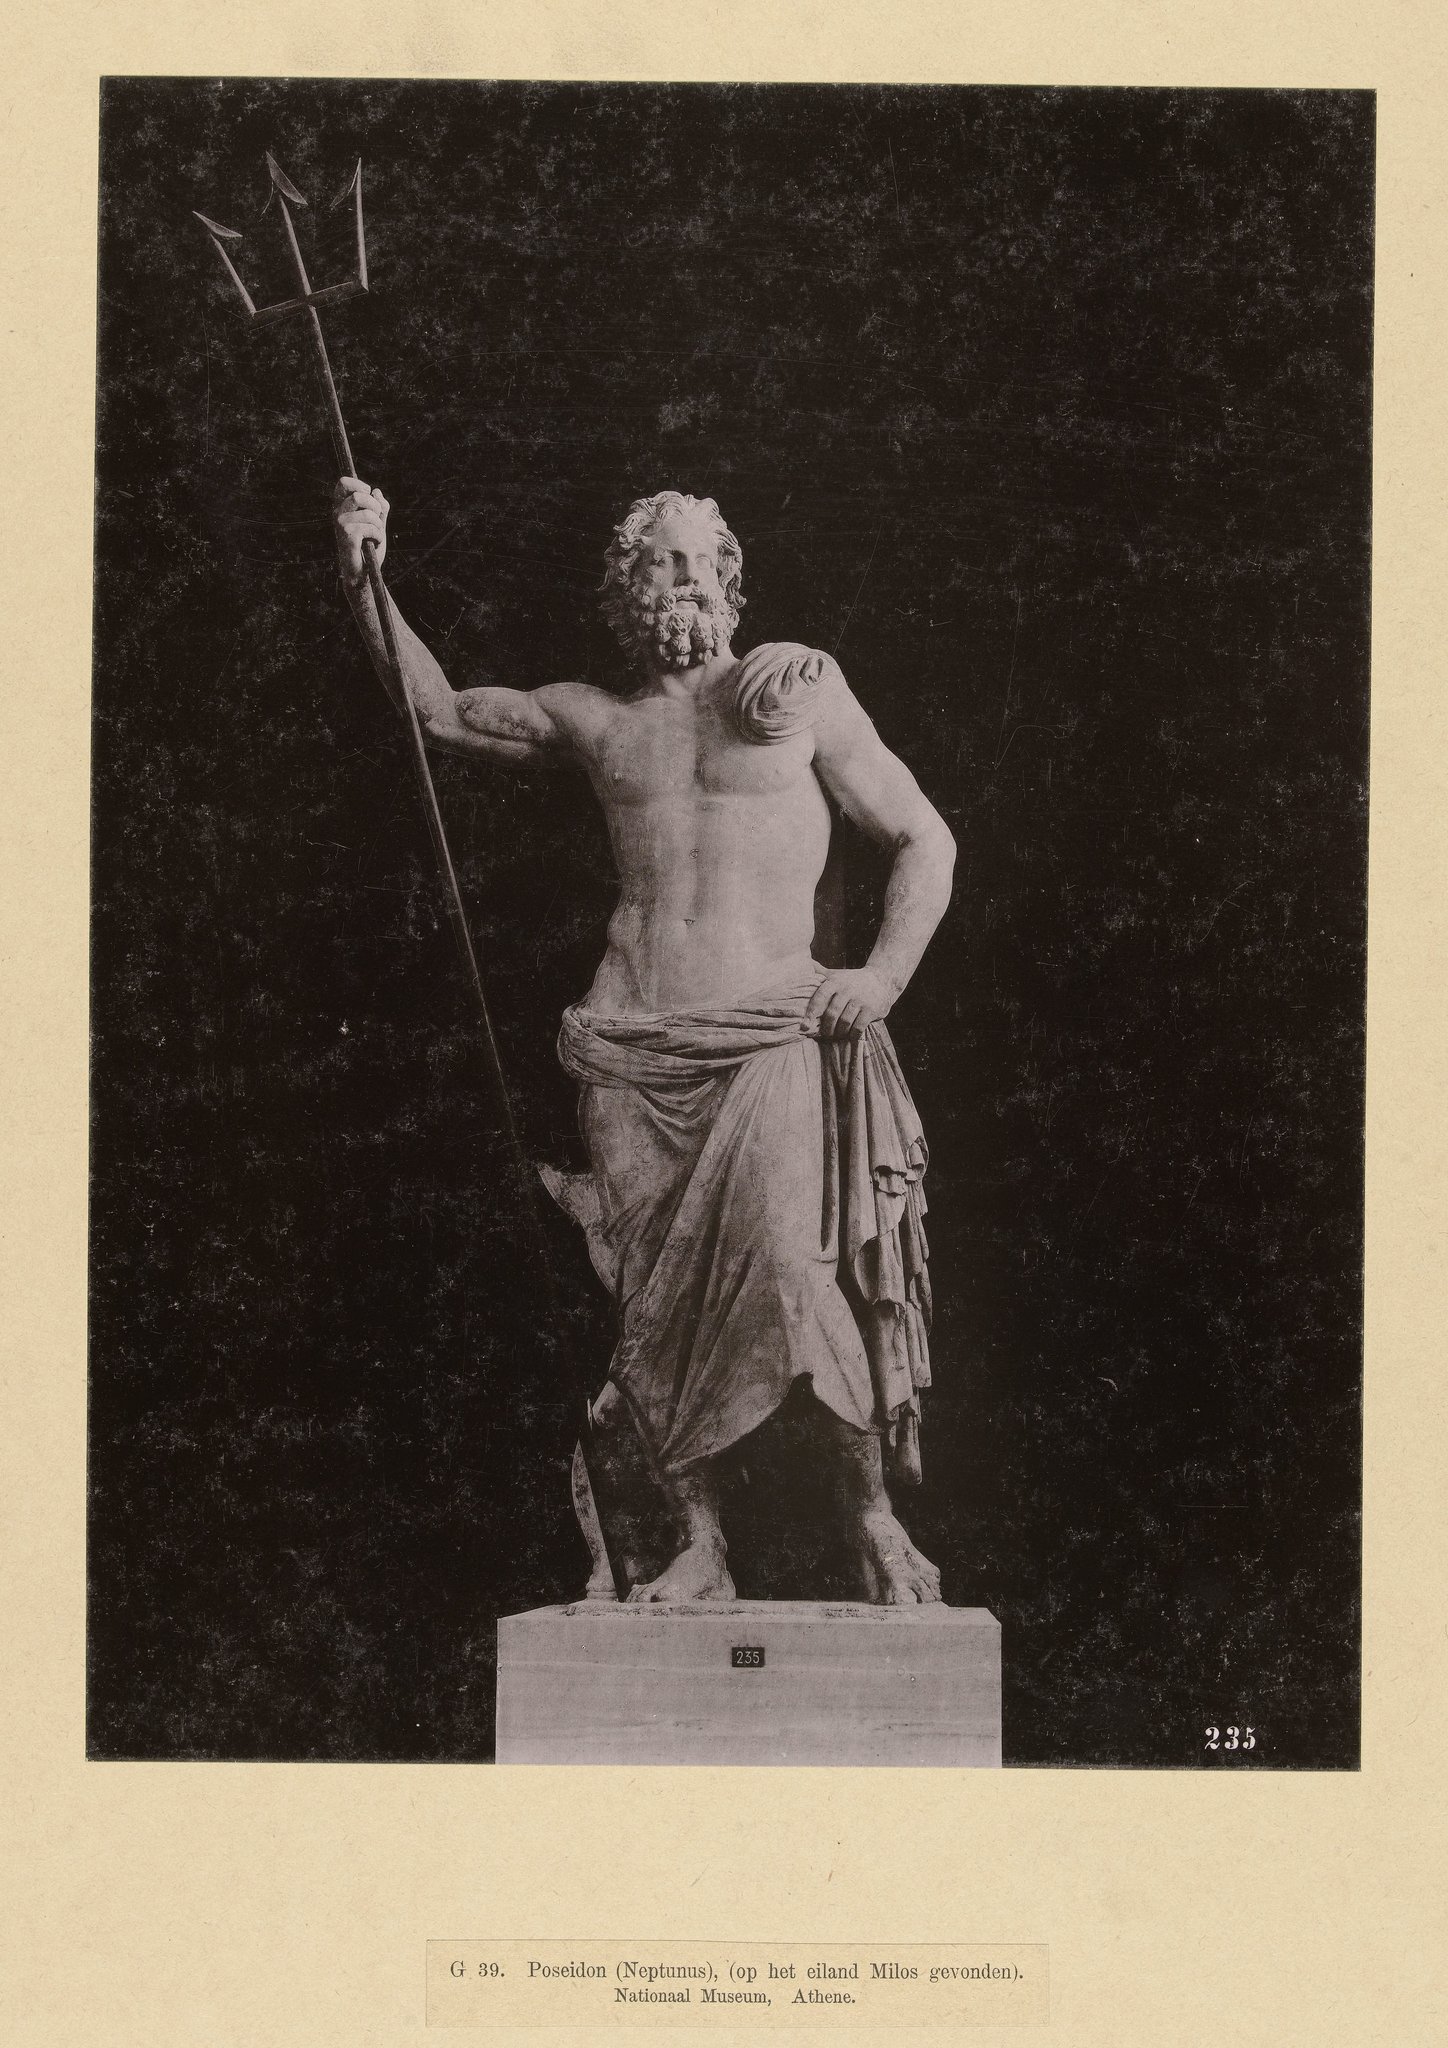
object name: photomechanical print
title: G 39. Poseidon (Neptunus), (op het eiland Milos gevonden). Nationaal Museum, Athene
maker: Anonymous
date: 1890-1893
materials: cardboard, paper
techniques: photograph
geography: athens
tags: (story of) neptune (poseidon), piece of sculpture, reproduction of a piece of sculpture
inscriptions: stamp: ‘Gemeentelijke bibliotheek/ Rotterdam’, number: ‘235’, title: ‘G 39. Poseidon (Neptunus), (op het eiland Milos gevonden)./ Nationaal Museum, Athene.’, check stamp: ‘Bristol/ L.M.’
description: Onderdeel van een groep door fotograaf Richard Polak op reis verzamelde foto’s. Deze fotomechanische afdruk is samen met andere op zijn reizen verzamelde foto's tentoongesteld bij de Rotterdamsche Kunstkring (1895), Arti en Amicitiae te Amsterdam (1897-1898?) en Societeit 't Collegie te Kampen (datum vooralsnog onbekend).